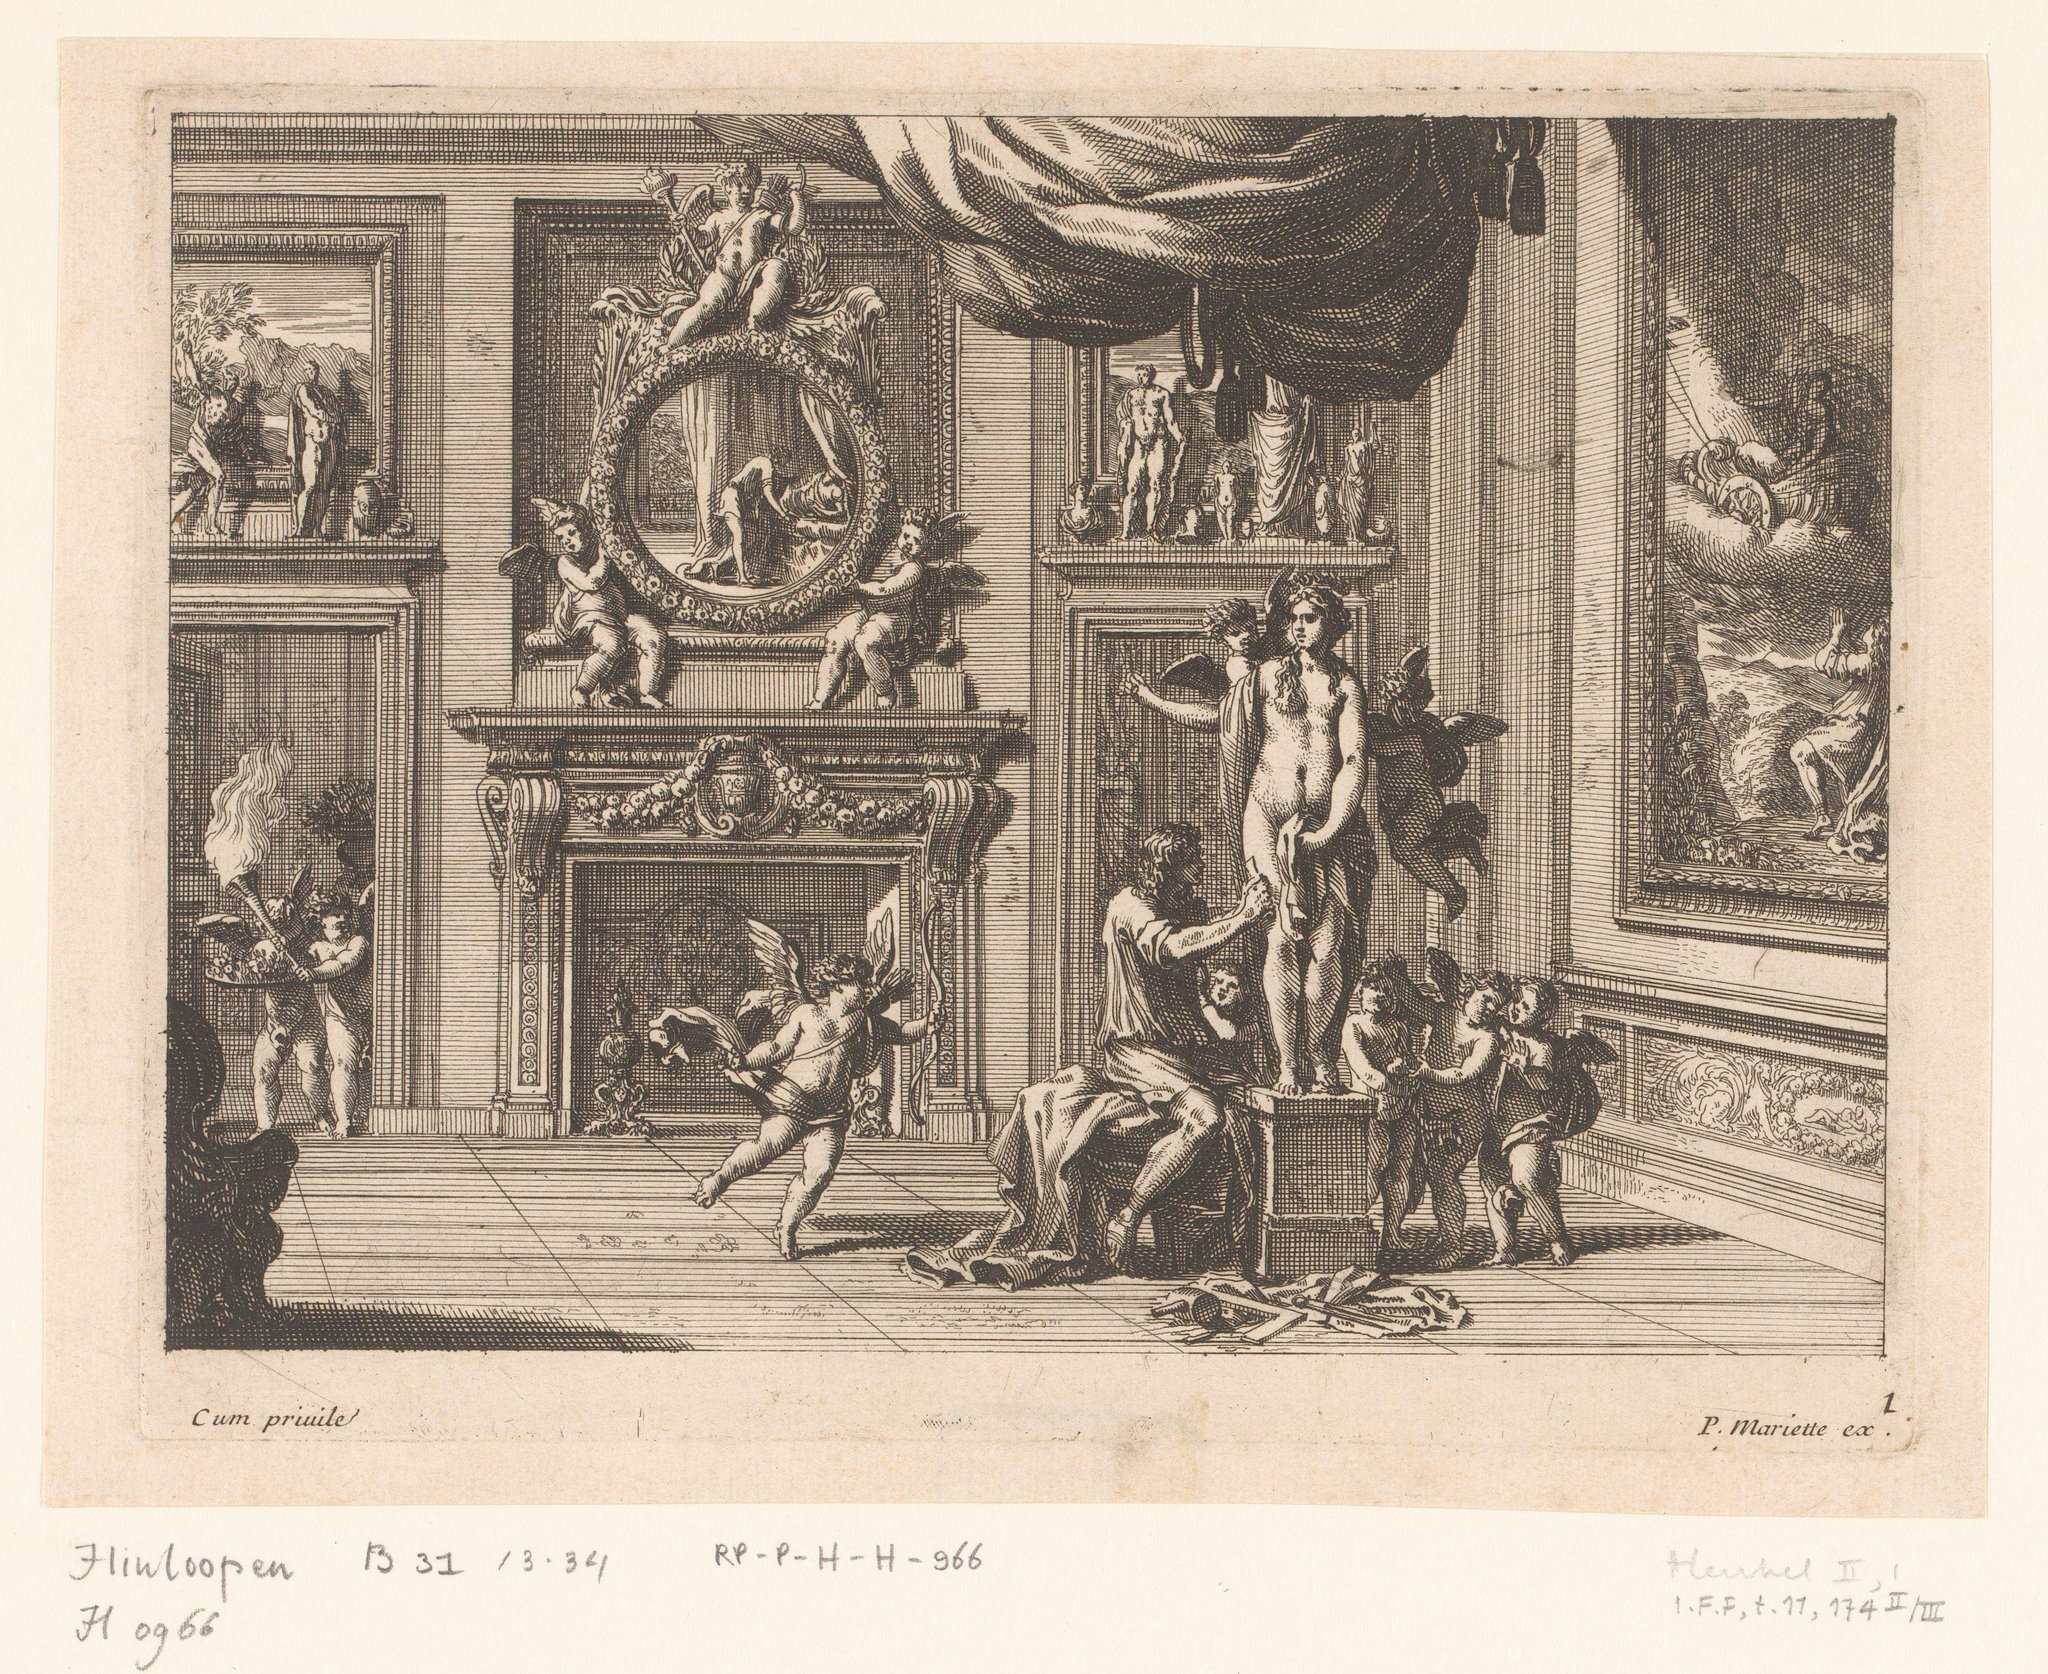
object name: print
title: Mythologische scènes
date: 1628-1682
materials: paper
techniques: etching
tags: pygmalion falls in love with the statue he is carving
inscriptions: collector's mark: Lugt 11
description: Maakt deel uit van een twintigdelige serie met mythologische scènes.